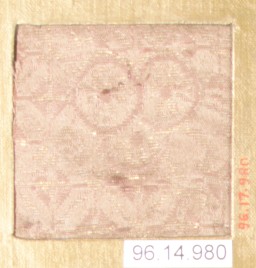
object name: piece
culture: japanese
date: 1701-1900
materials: silk